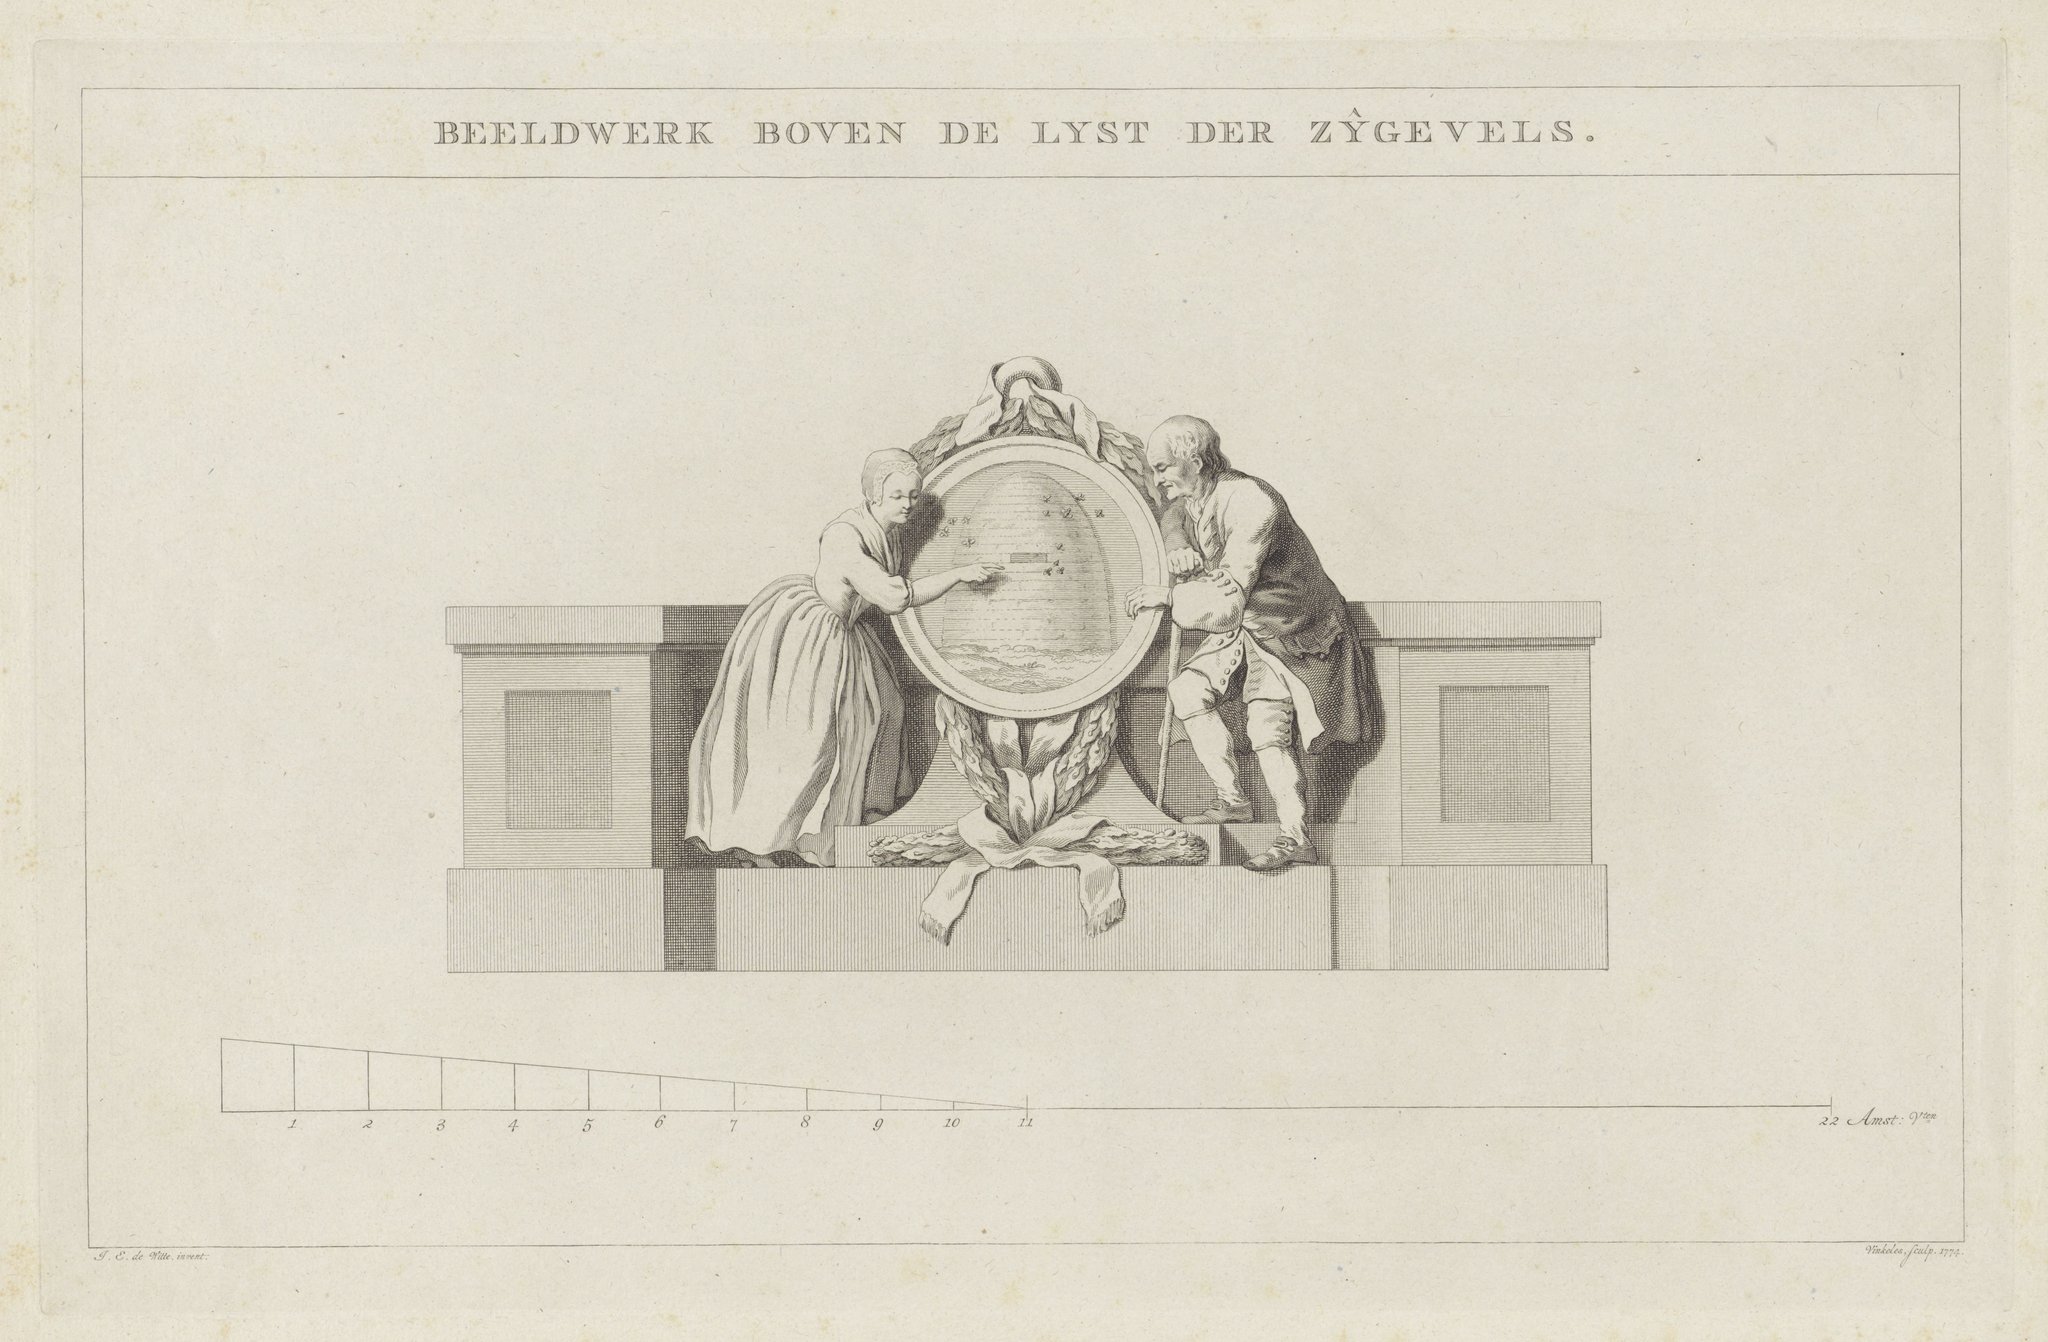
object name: print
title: Beeldwerk boven de lyst der zijgevels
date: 1774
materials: paper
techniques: engraving, etching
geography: amsterdam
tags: symbolic representations, allegories and emblems ~ the theatre, theatre (building), bee-hive, piece of sculpture, reproduction of a piece of sculpture, amsterdam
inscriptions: collector's mark: Lugt 2228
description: Illustratie voor: Witte, Jacob Eduard de. Afbeeldingen van den schouwburg te Amsterdam. Amsterdam: Johannes Smit, 1774.